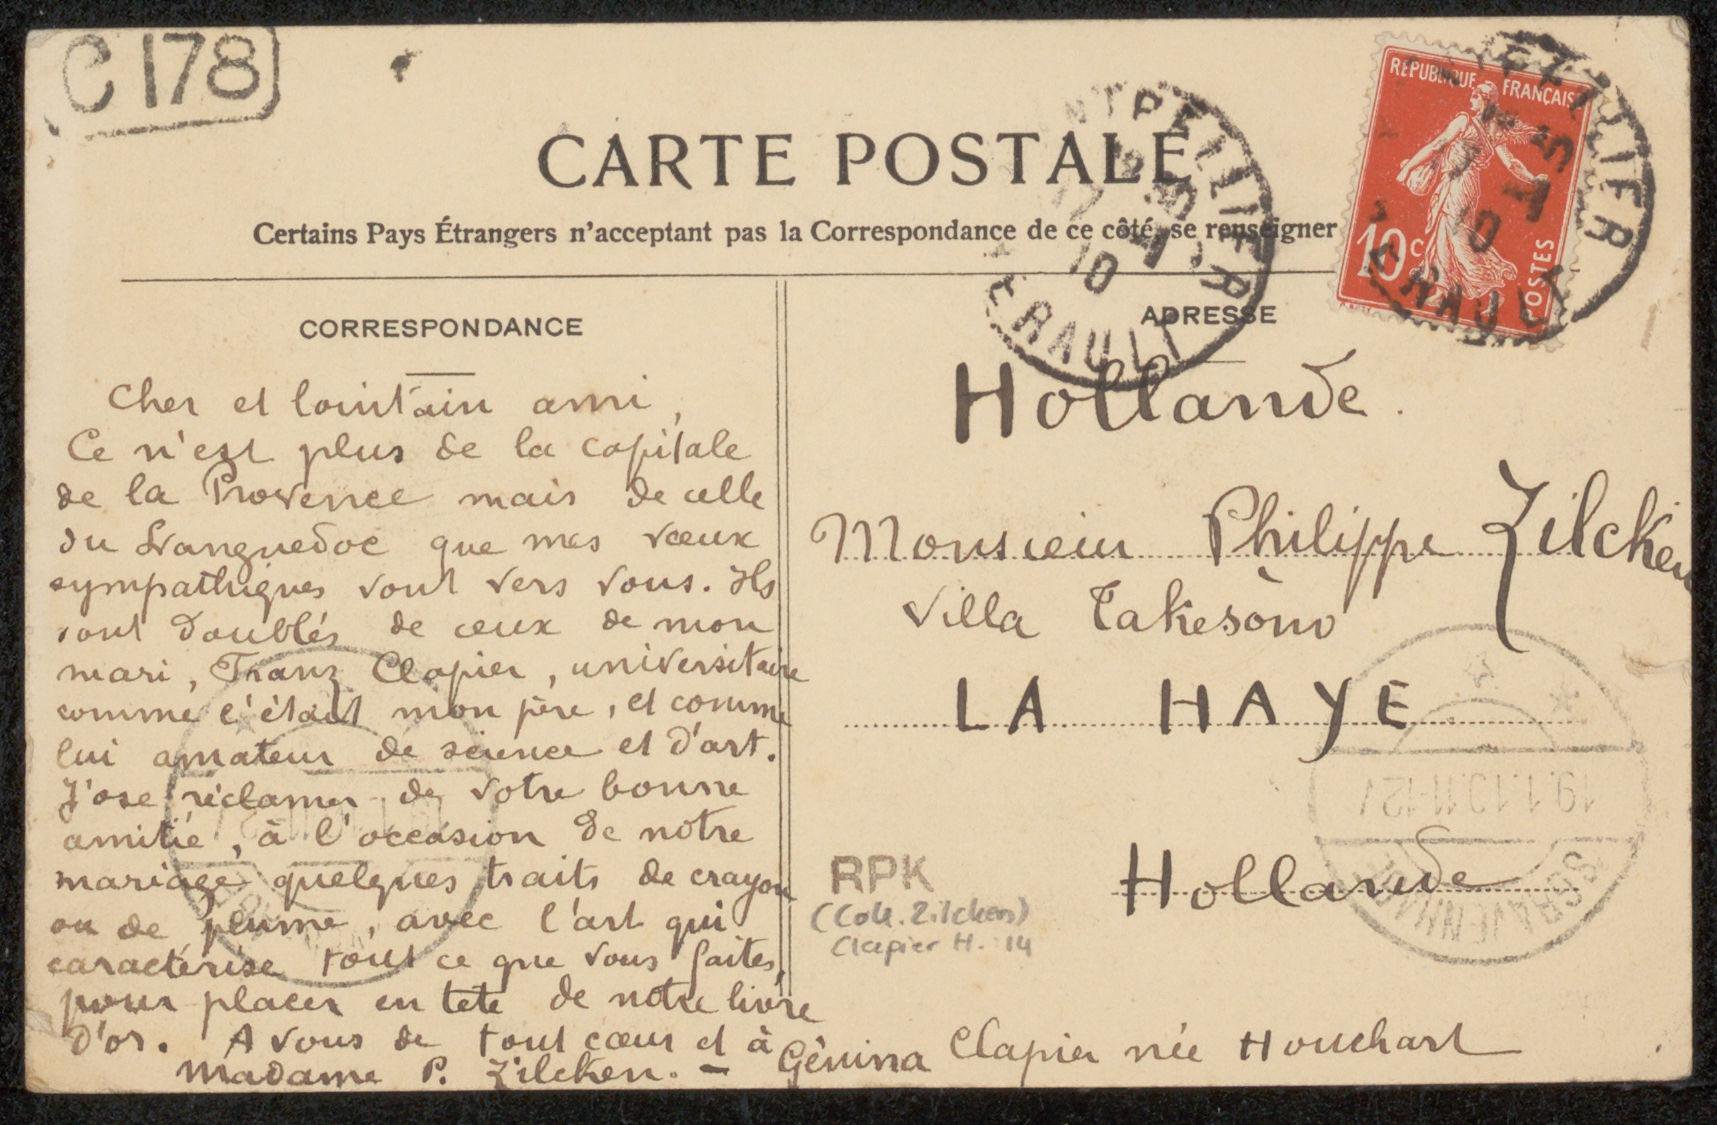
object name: ansichtkaart, prentbriefkaart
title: Prentbriefkaart aan Philip Zilcken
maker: eugénie clapier-houchart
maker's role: dichter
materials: cardboard, ink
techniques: photograph, pen, writing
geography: nancy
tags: the hague, draughtsman, philip zilcken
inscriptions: collector's mark: ‘RPK’